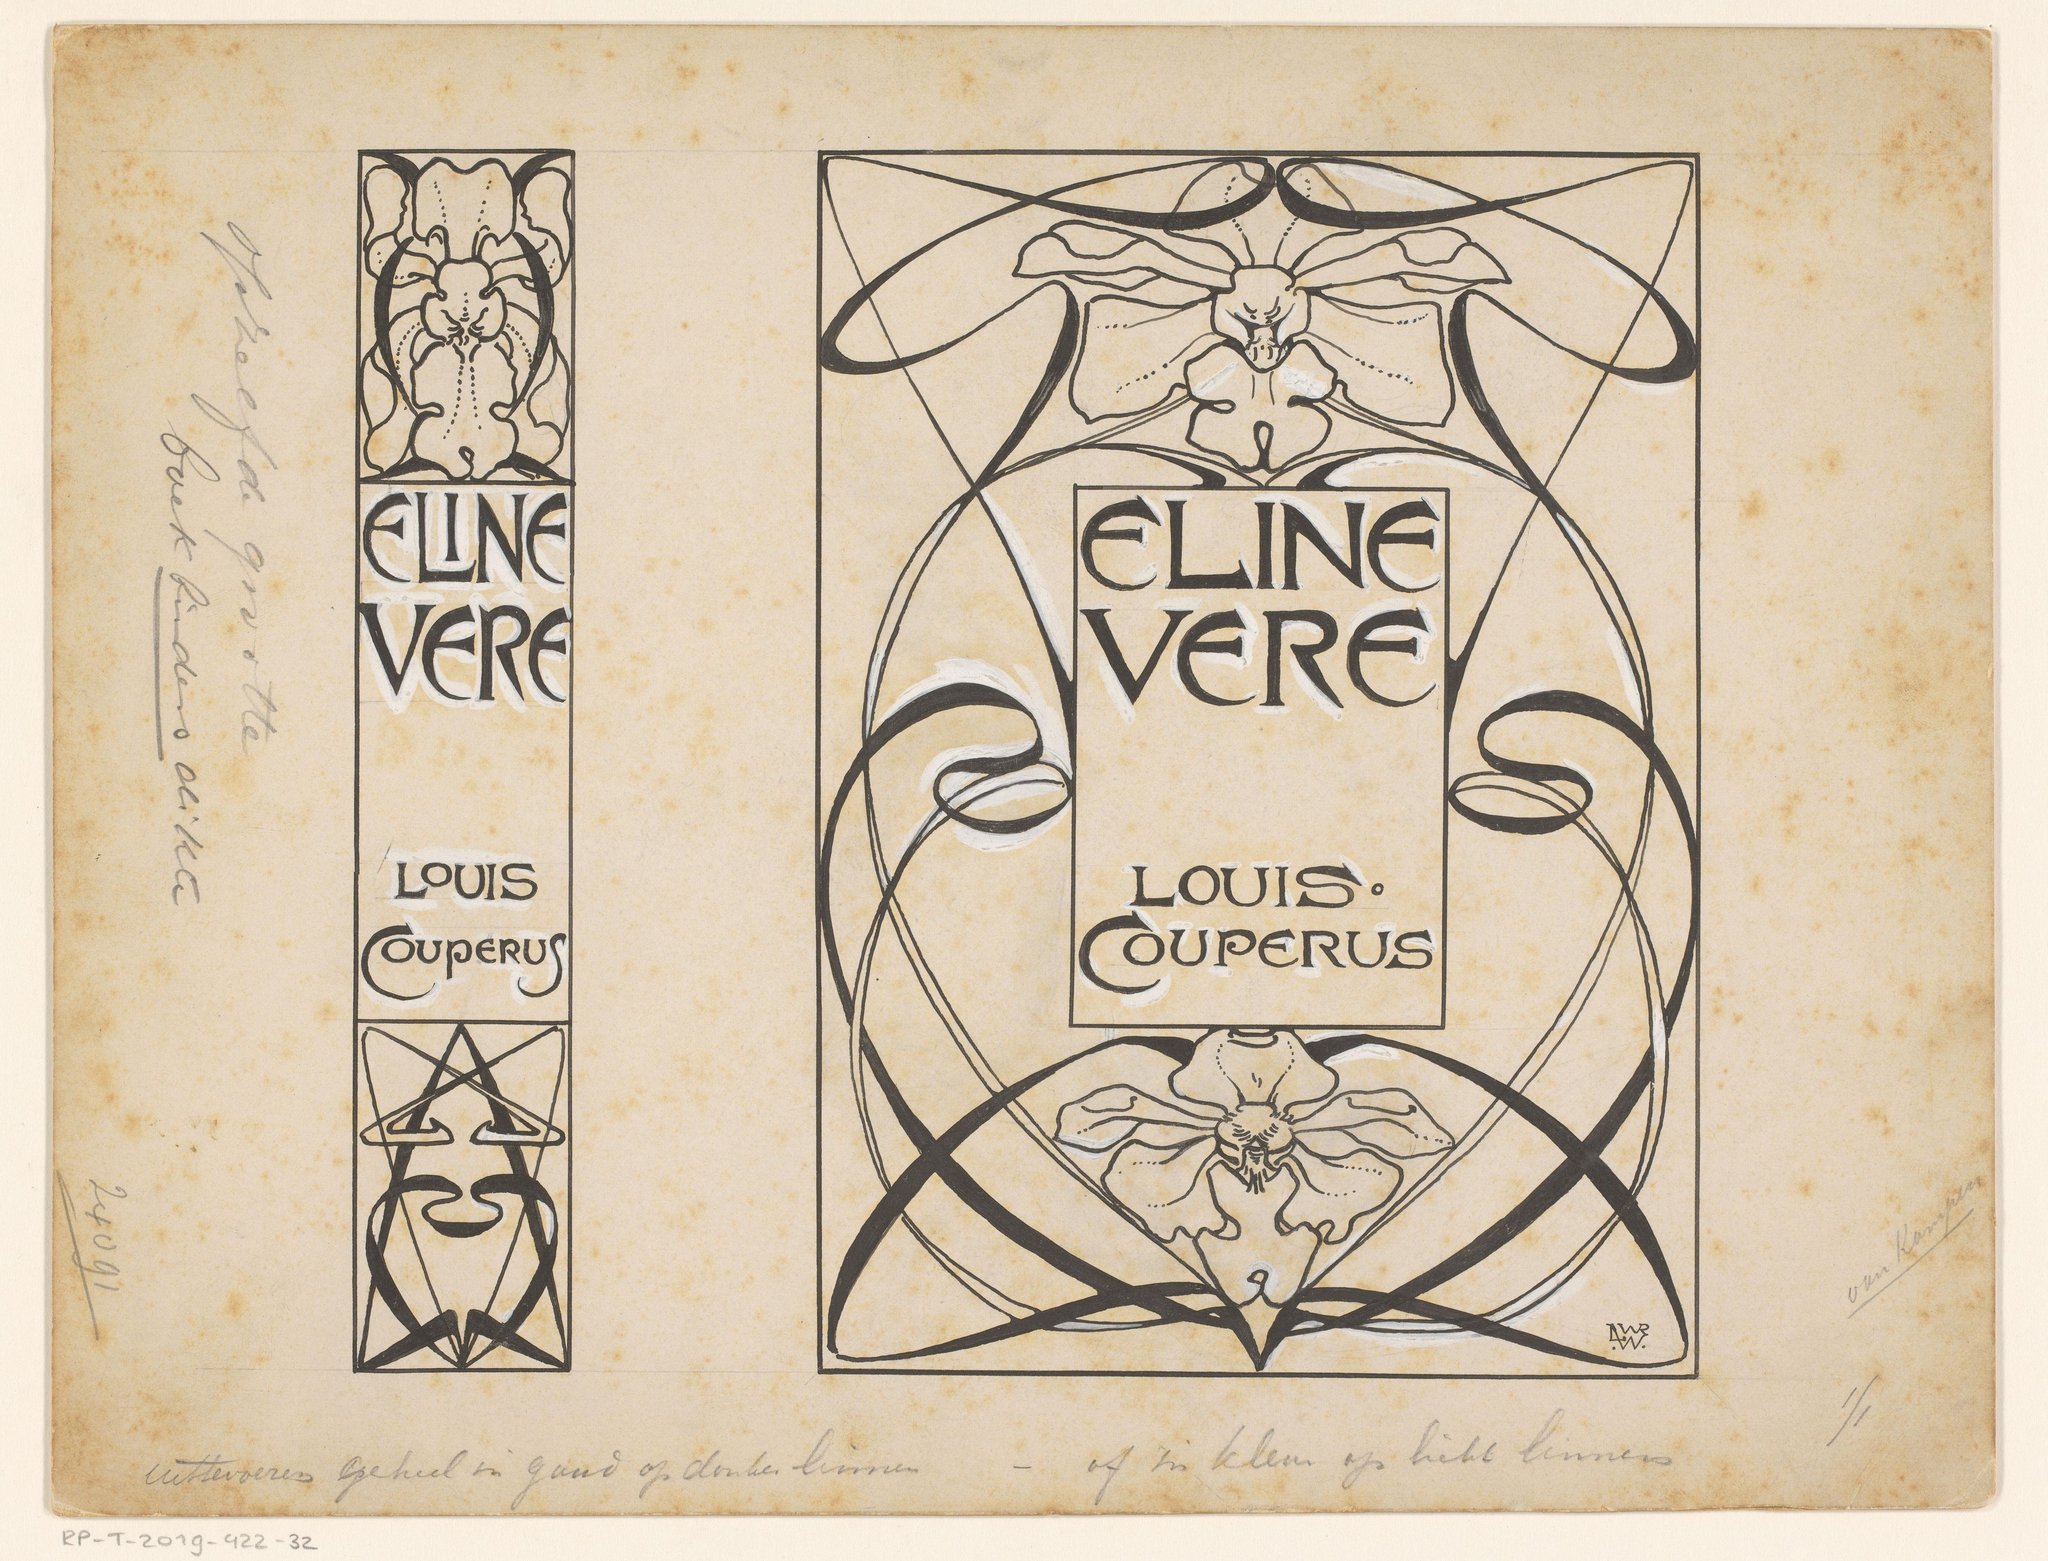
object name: study for binding design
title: Bandontwerp voor: Louis Couperus, Eline Vere, 1898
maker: willem wenckebach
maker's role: designer, draughtsman, painter, print maker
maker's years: 1860-1937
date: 1898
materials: cardboard, paint, ink, pencil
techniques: brush, pen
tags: ornament ~ round and curved forms, flowers ~ ornament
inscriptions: annotation: ‘opzelfde grootte/ boekbindersdikte/ uittevoeren geheel in goud op donker linnen - of in kleur op licht linnen/ van Kampen’, collector's mark: Lugt 2228, :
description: Bandontwerp met bloemen en symmetrisch lijnenspel. In het midden een rechthoekig kader met titel en auteursnaam.